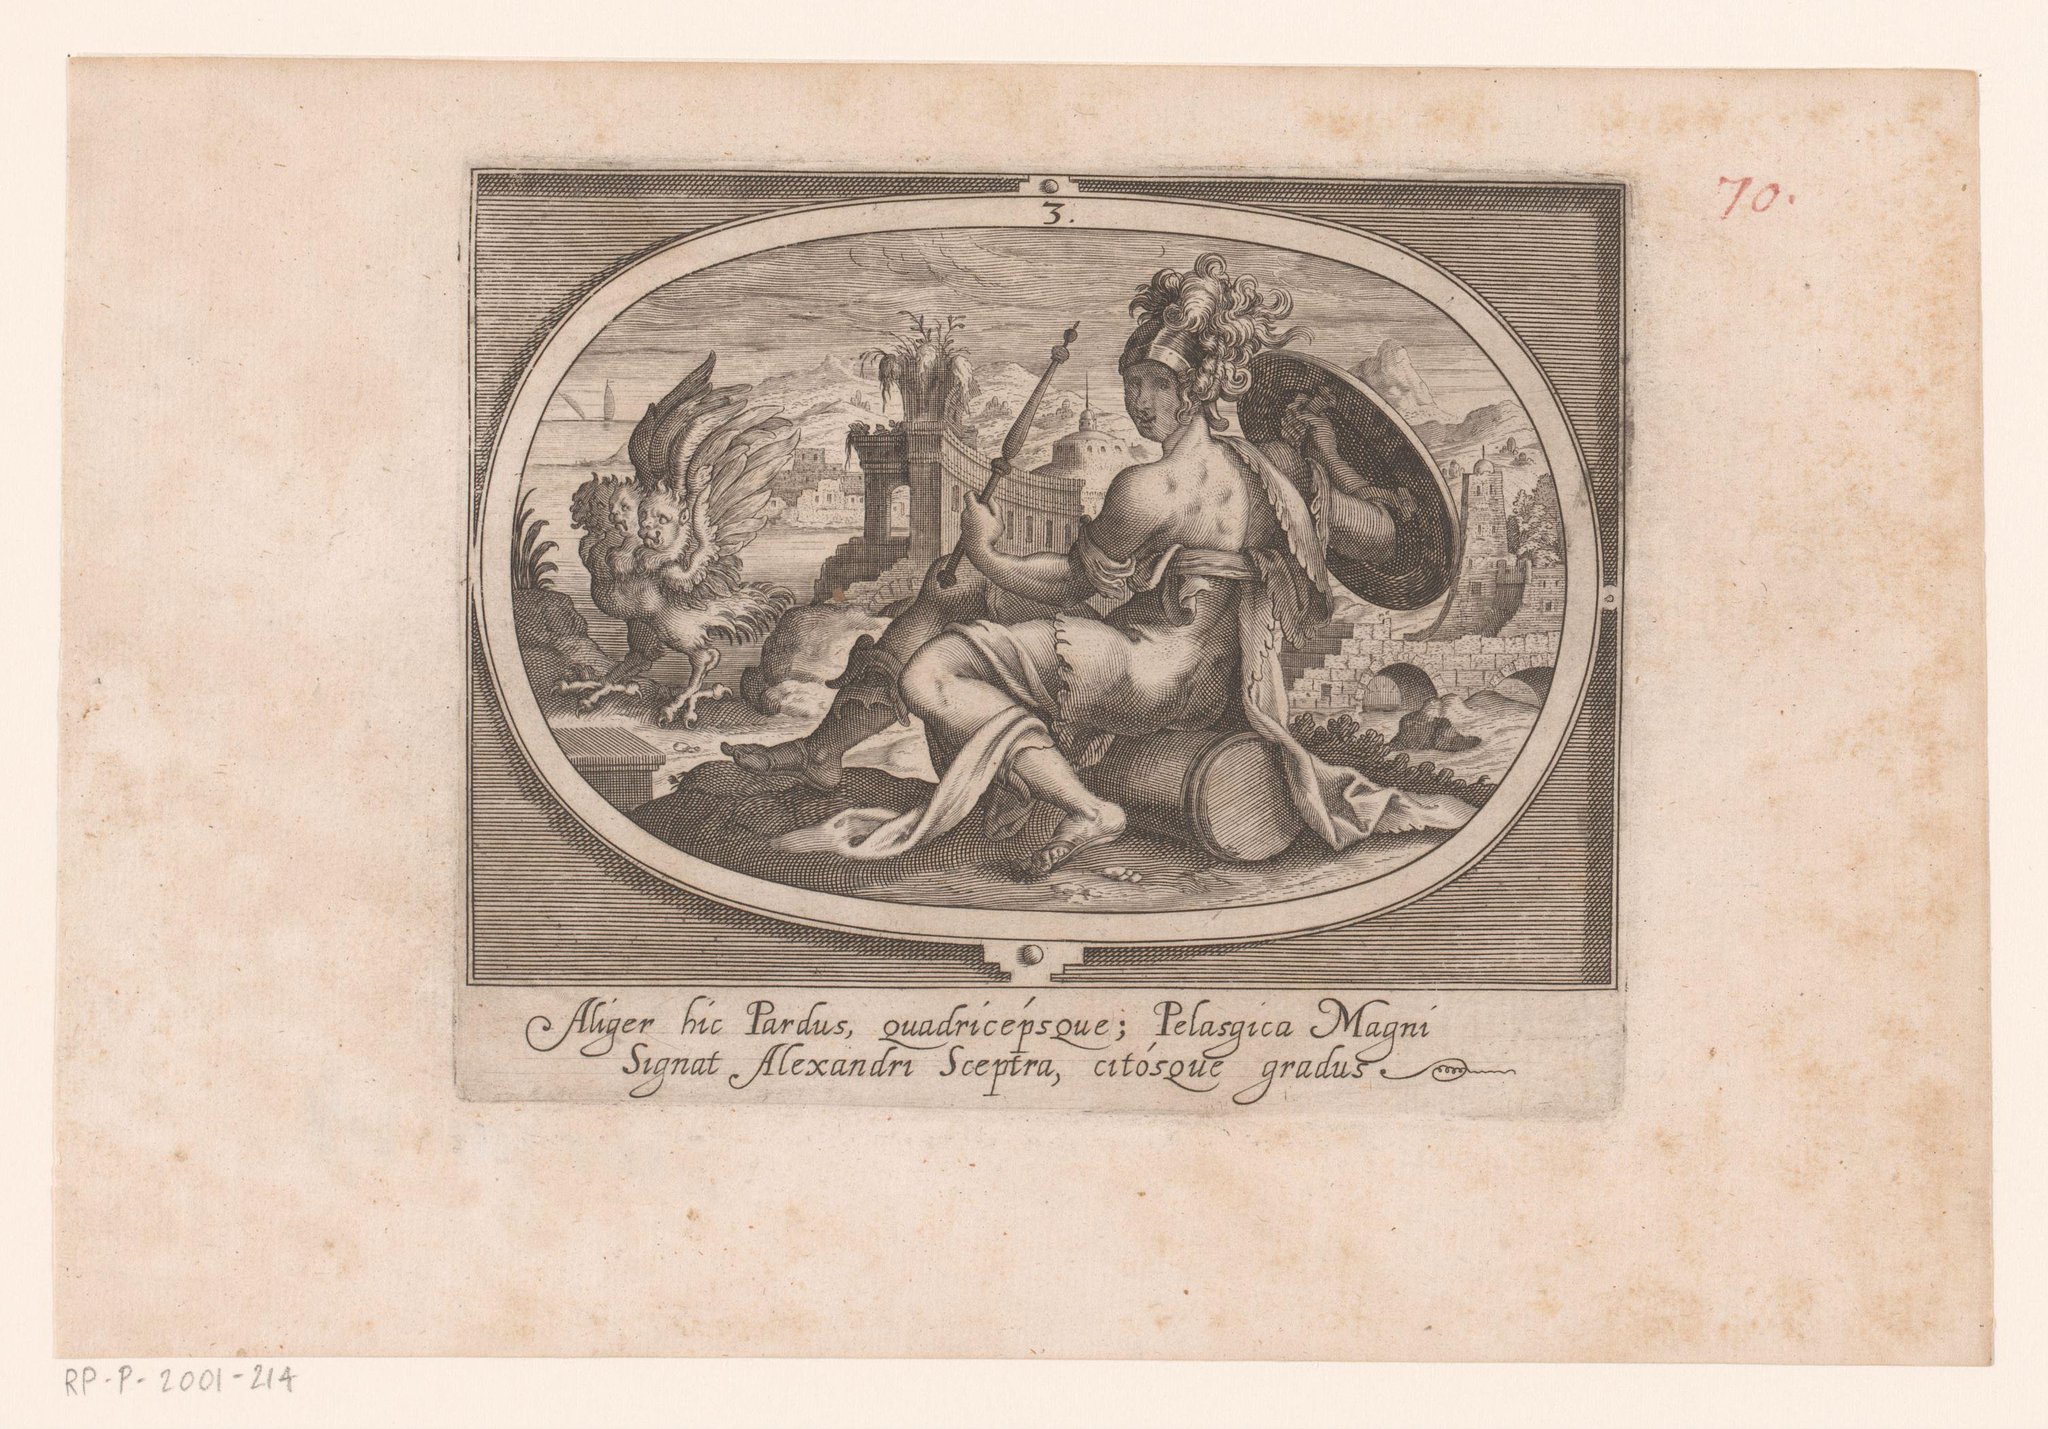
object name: print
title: Personificatie van het Macedonische Rijk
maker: heinrich ulrich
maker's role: draughtsman, painter, print maker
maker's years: 1572-1671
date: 1582-1671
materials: paper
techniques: engraving, intaglio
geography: germany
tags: four great beasts rising from the sea ~ daniel's visions, personifications of countries, nations, states, districts, etc., landscape with ruins, the leopard with four bird's wings and four heads ~ daniel's visions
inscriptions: number: ‘70’, collector's mark: Lugt 2228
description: Deze prent maakt deel uit van een serie van vier prenten met vrouwelijke personificaties van de vier opeenvolgende wereldrijken zoals beschreven in het zevende hoofdstuk van het boek Daniël.